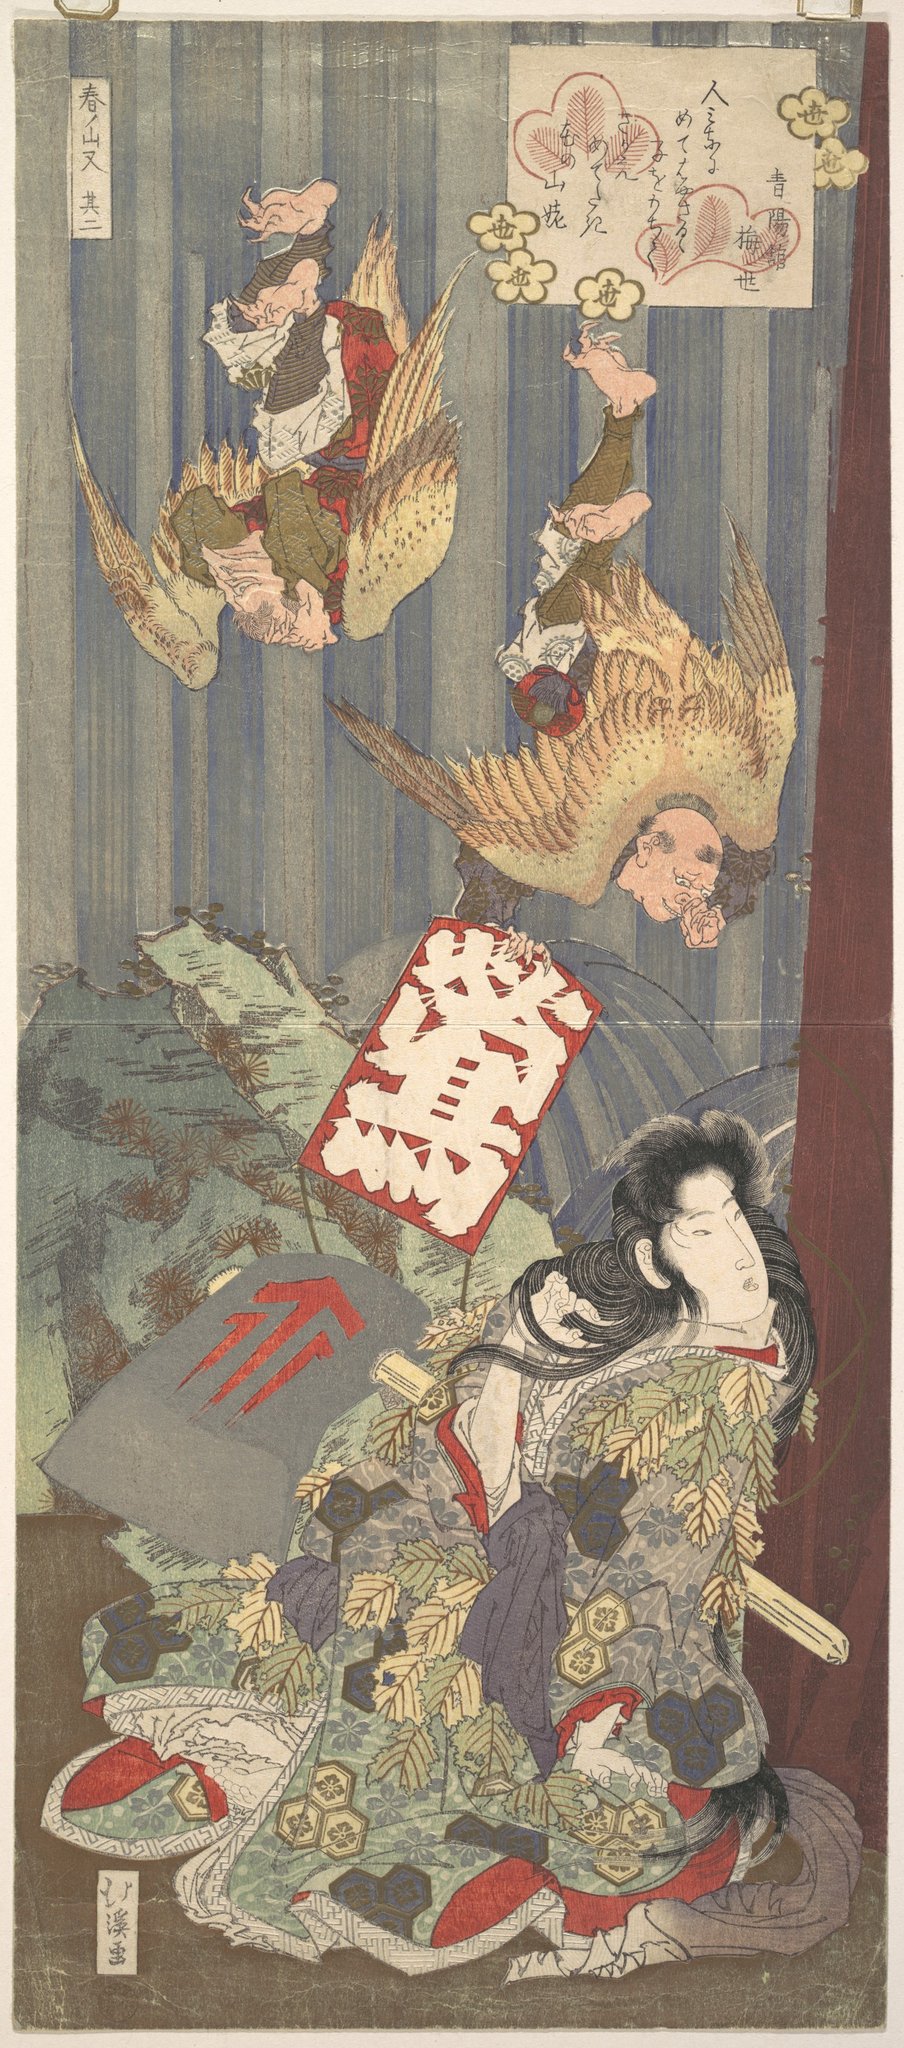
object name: print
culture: japanese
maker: totoya hokkei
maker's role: artist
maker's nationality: japanese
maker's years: 1780-1850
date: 1820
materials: ink, paper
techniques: surimono, woodblock print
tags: women,mythical creatures